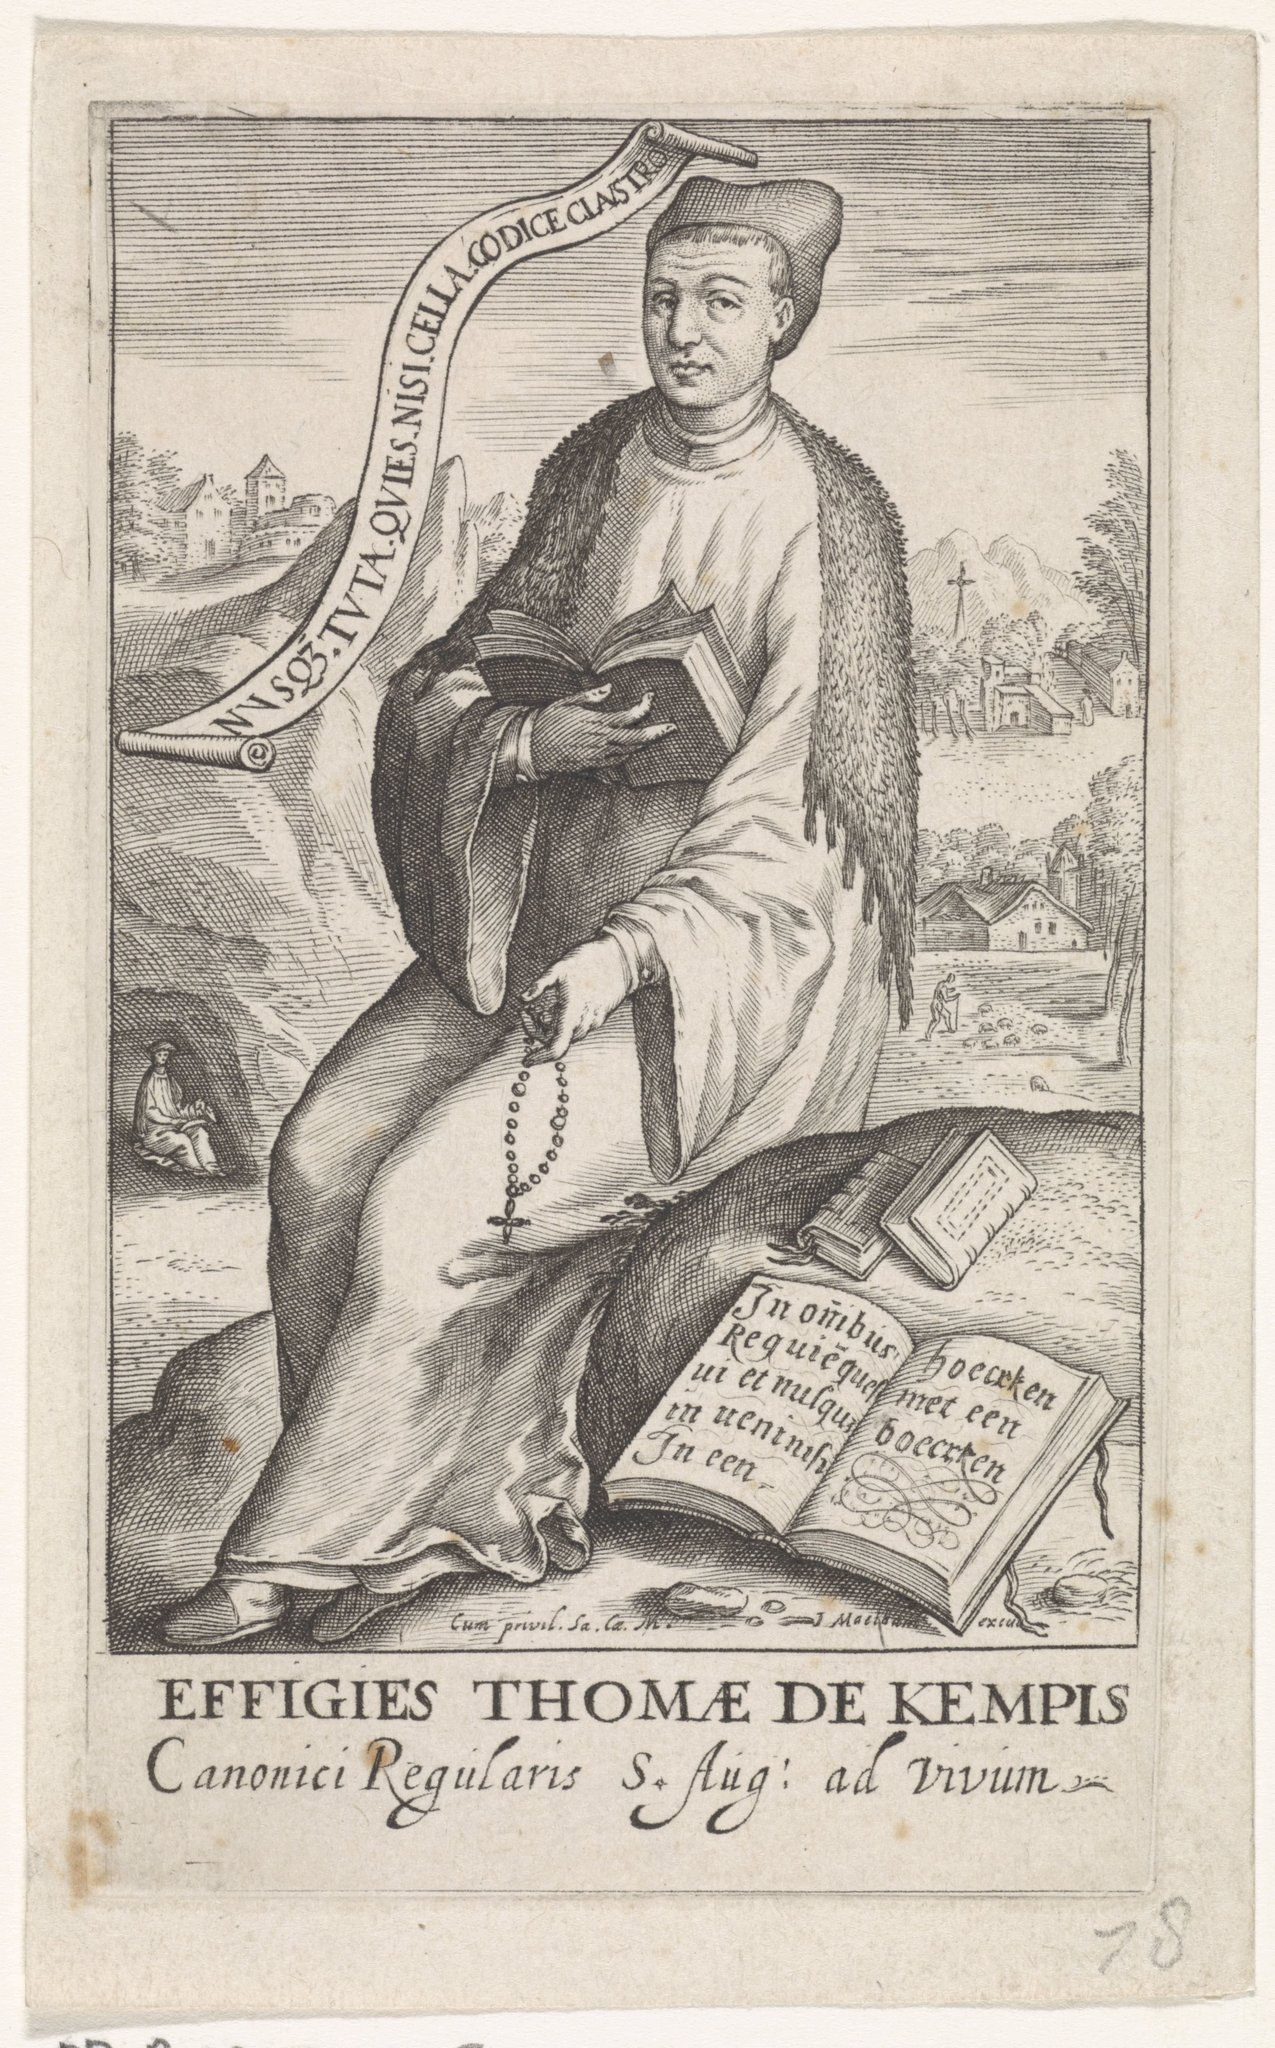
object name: print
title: Portret van Thomas à Kempis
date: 1601-1606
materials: paper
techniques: engraving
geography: haarlem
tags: priest, thomas à kempis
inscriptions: collector's mark: Lugt 240